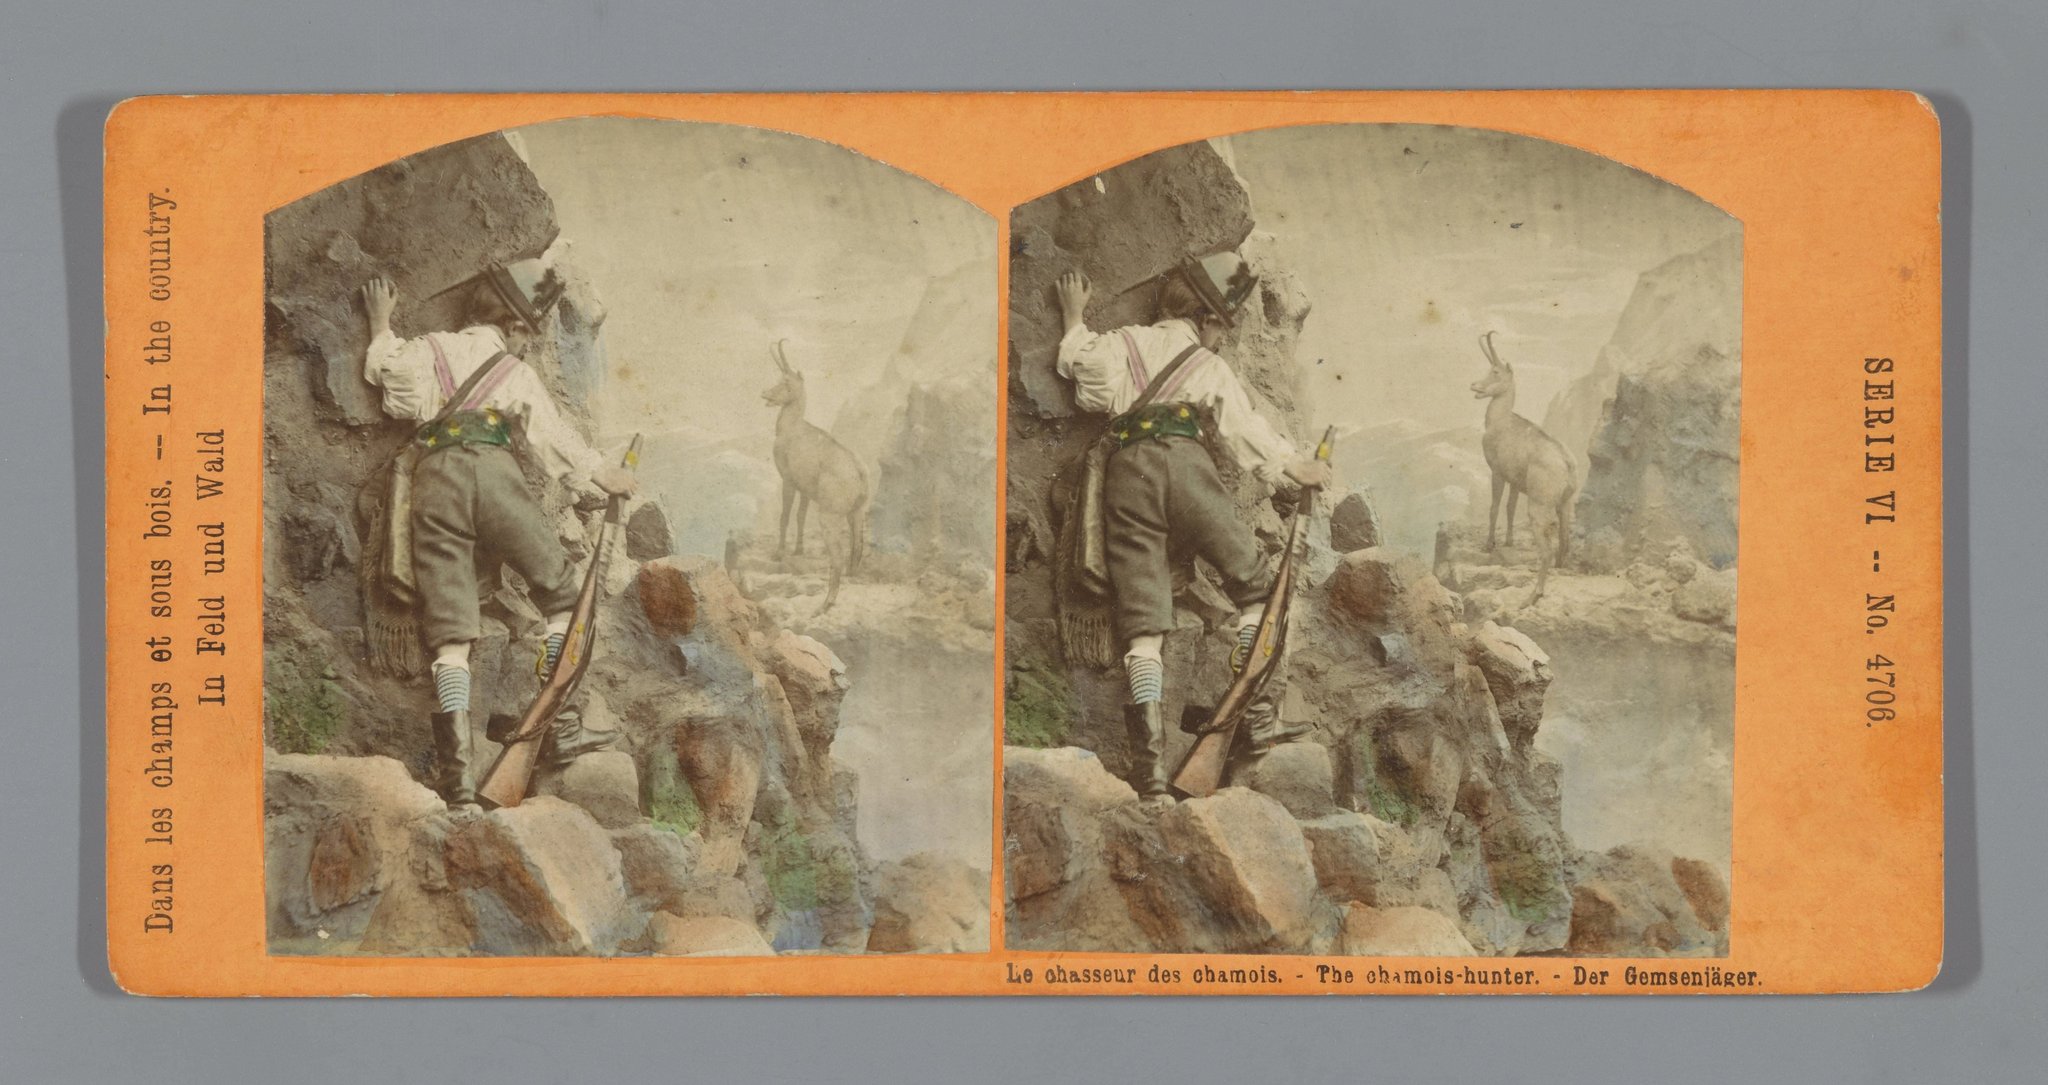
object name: stereograph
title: Dans les champs et sous bois / In the country / In Feld und Wald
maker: Anonymous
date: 1868-1890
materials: cardboard, paper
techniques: albumen print, hand coloring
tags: hoofed animals, hunter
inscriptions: number: ‘12’, inscription: ‘SERIE VI. -- No. 4706.’